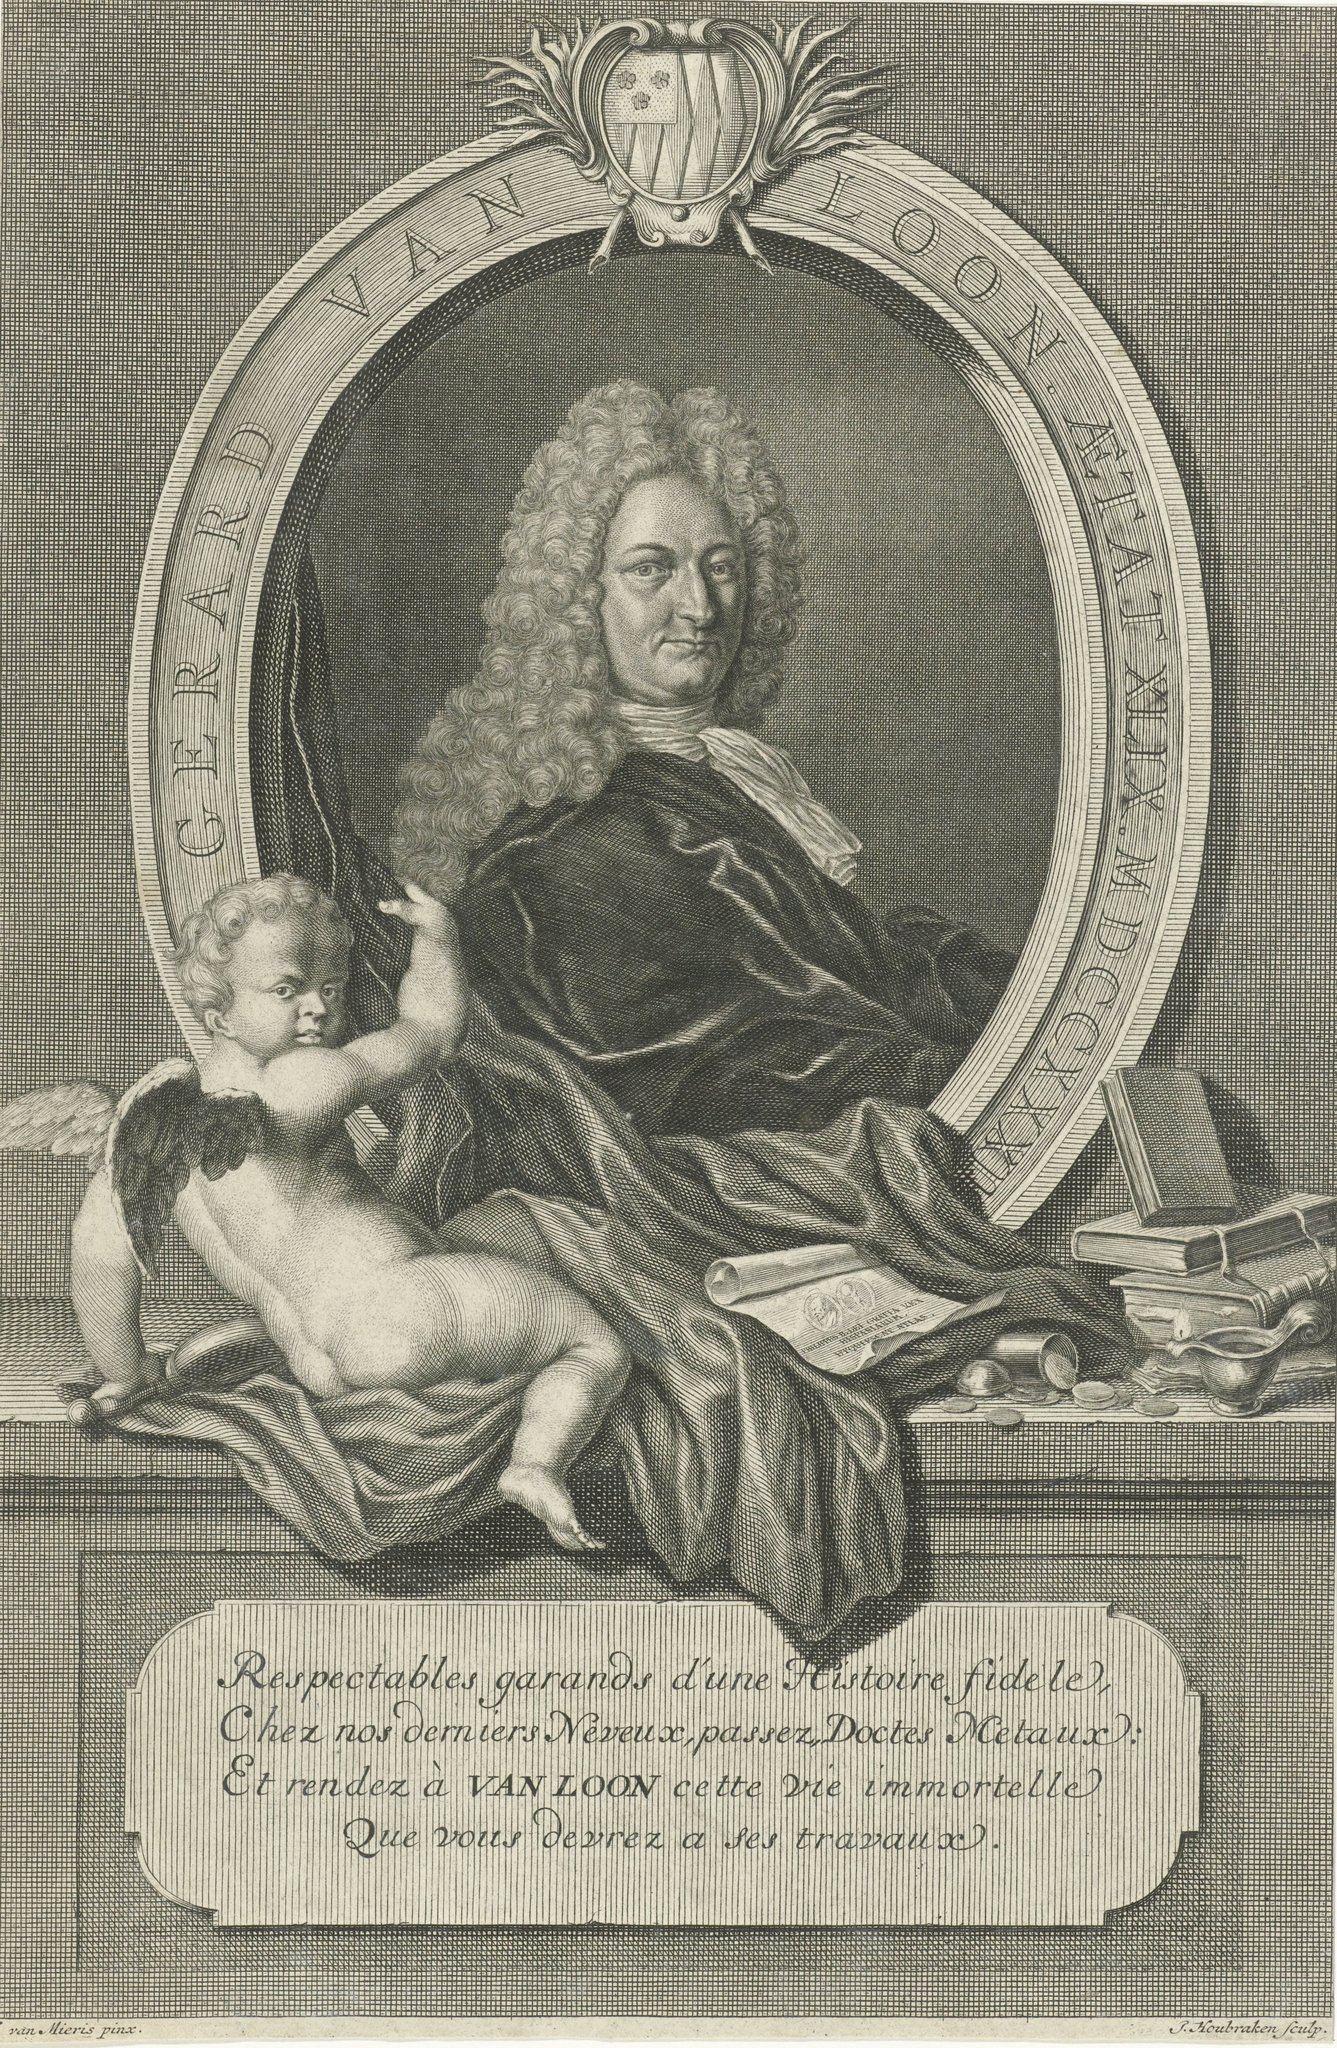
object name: print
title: Portret van Gerard van Loon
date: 1732-1780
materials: paper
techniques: engraving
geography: amsterdam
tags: designer, gerard van loon, cupids: 'amores', 'amoretti', 'putti'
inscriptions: collector's mark: Lugt 2228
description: Buste naar rechts van Gerard van Loon op 49-jarige leeftijd in een ovaal met randschrift en met bovenaan een wapen. Het portret rust op een sokkel met daarop een cartouche met een vierregelig vers in het Frans. Links op de sokkel naast het portret een putto die een stuk gordijn openhoudt en rechts boeken, een olielampje en munten.